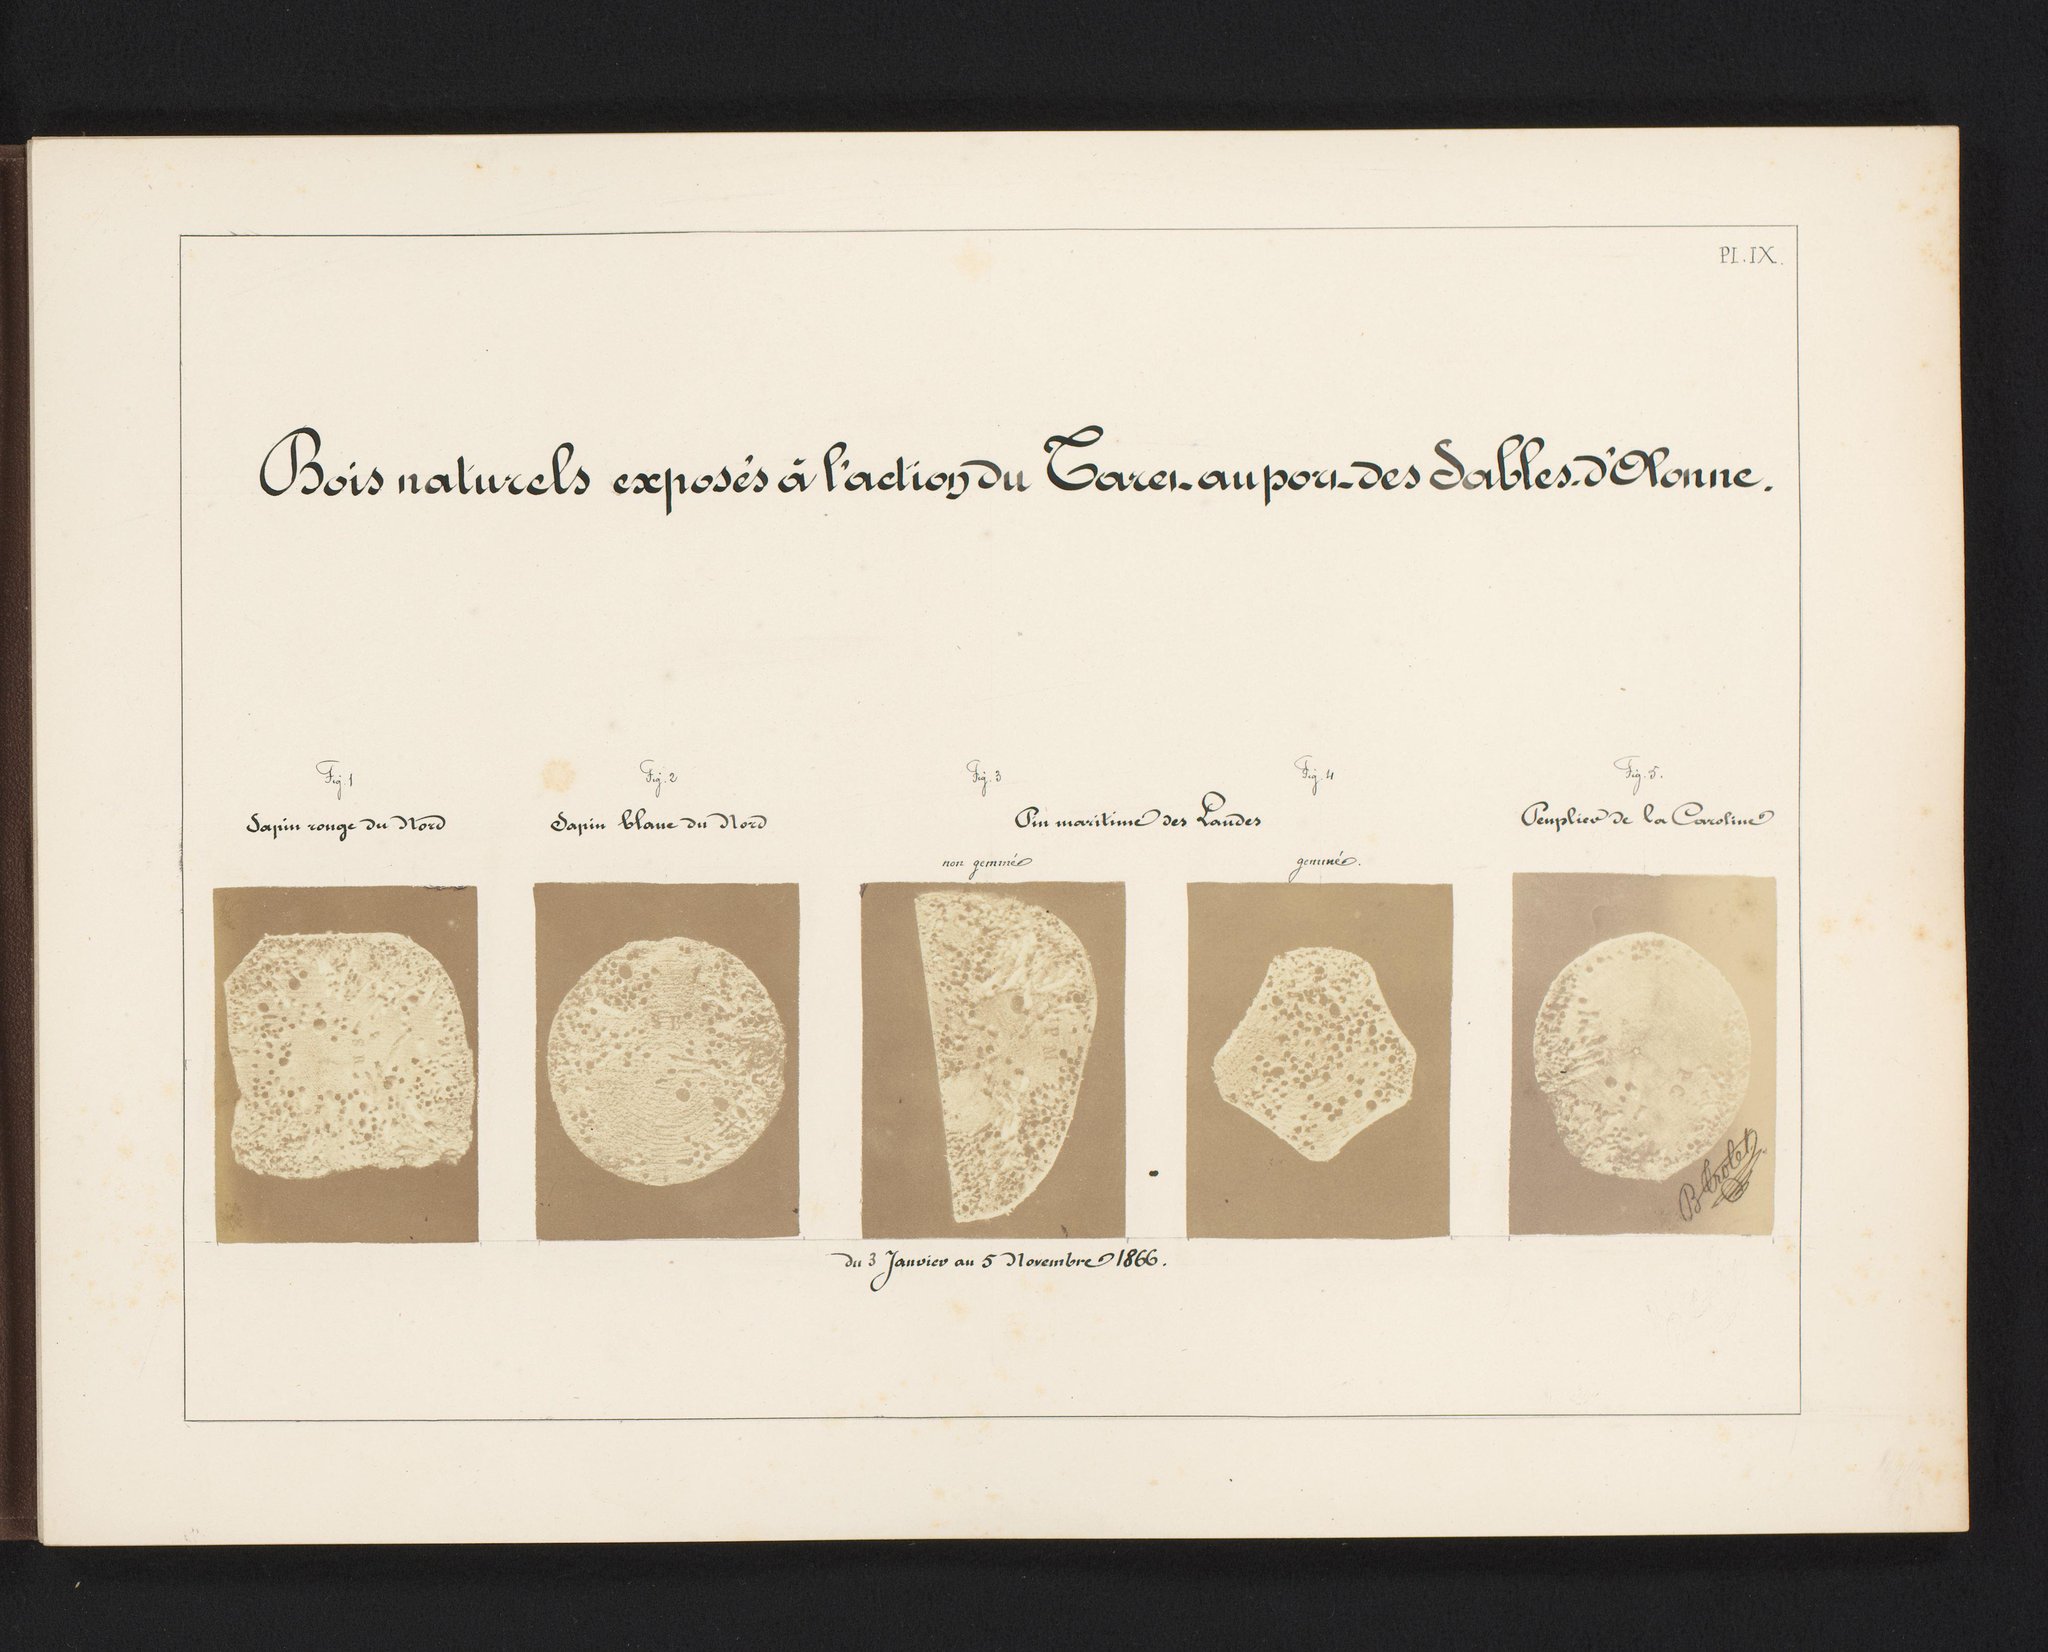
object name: photograph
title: Vijf stukken hout aangetast door wormen, afkomstig uit de haven van Les Sables-d'Olonne, Frankrijk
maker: b. crolet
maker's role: fotograaf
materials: cardboard, photographic support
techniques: albumen print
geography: france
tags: worms, wood, timber ~ building material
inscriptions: signature: ‘B. Crolet’, annotation: ‘Fig. 1/ Sapin rouge du Nord (...) 5 Novembre 1866.’, number: ‘Pl. IX.’